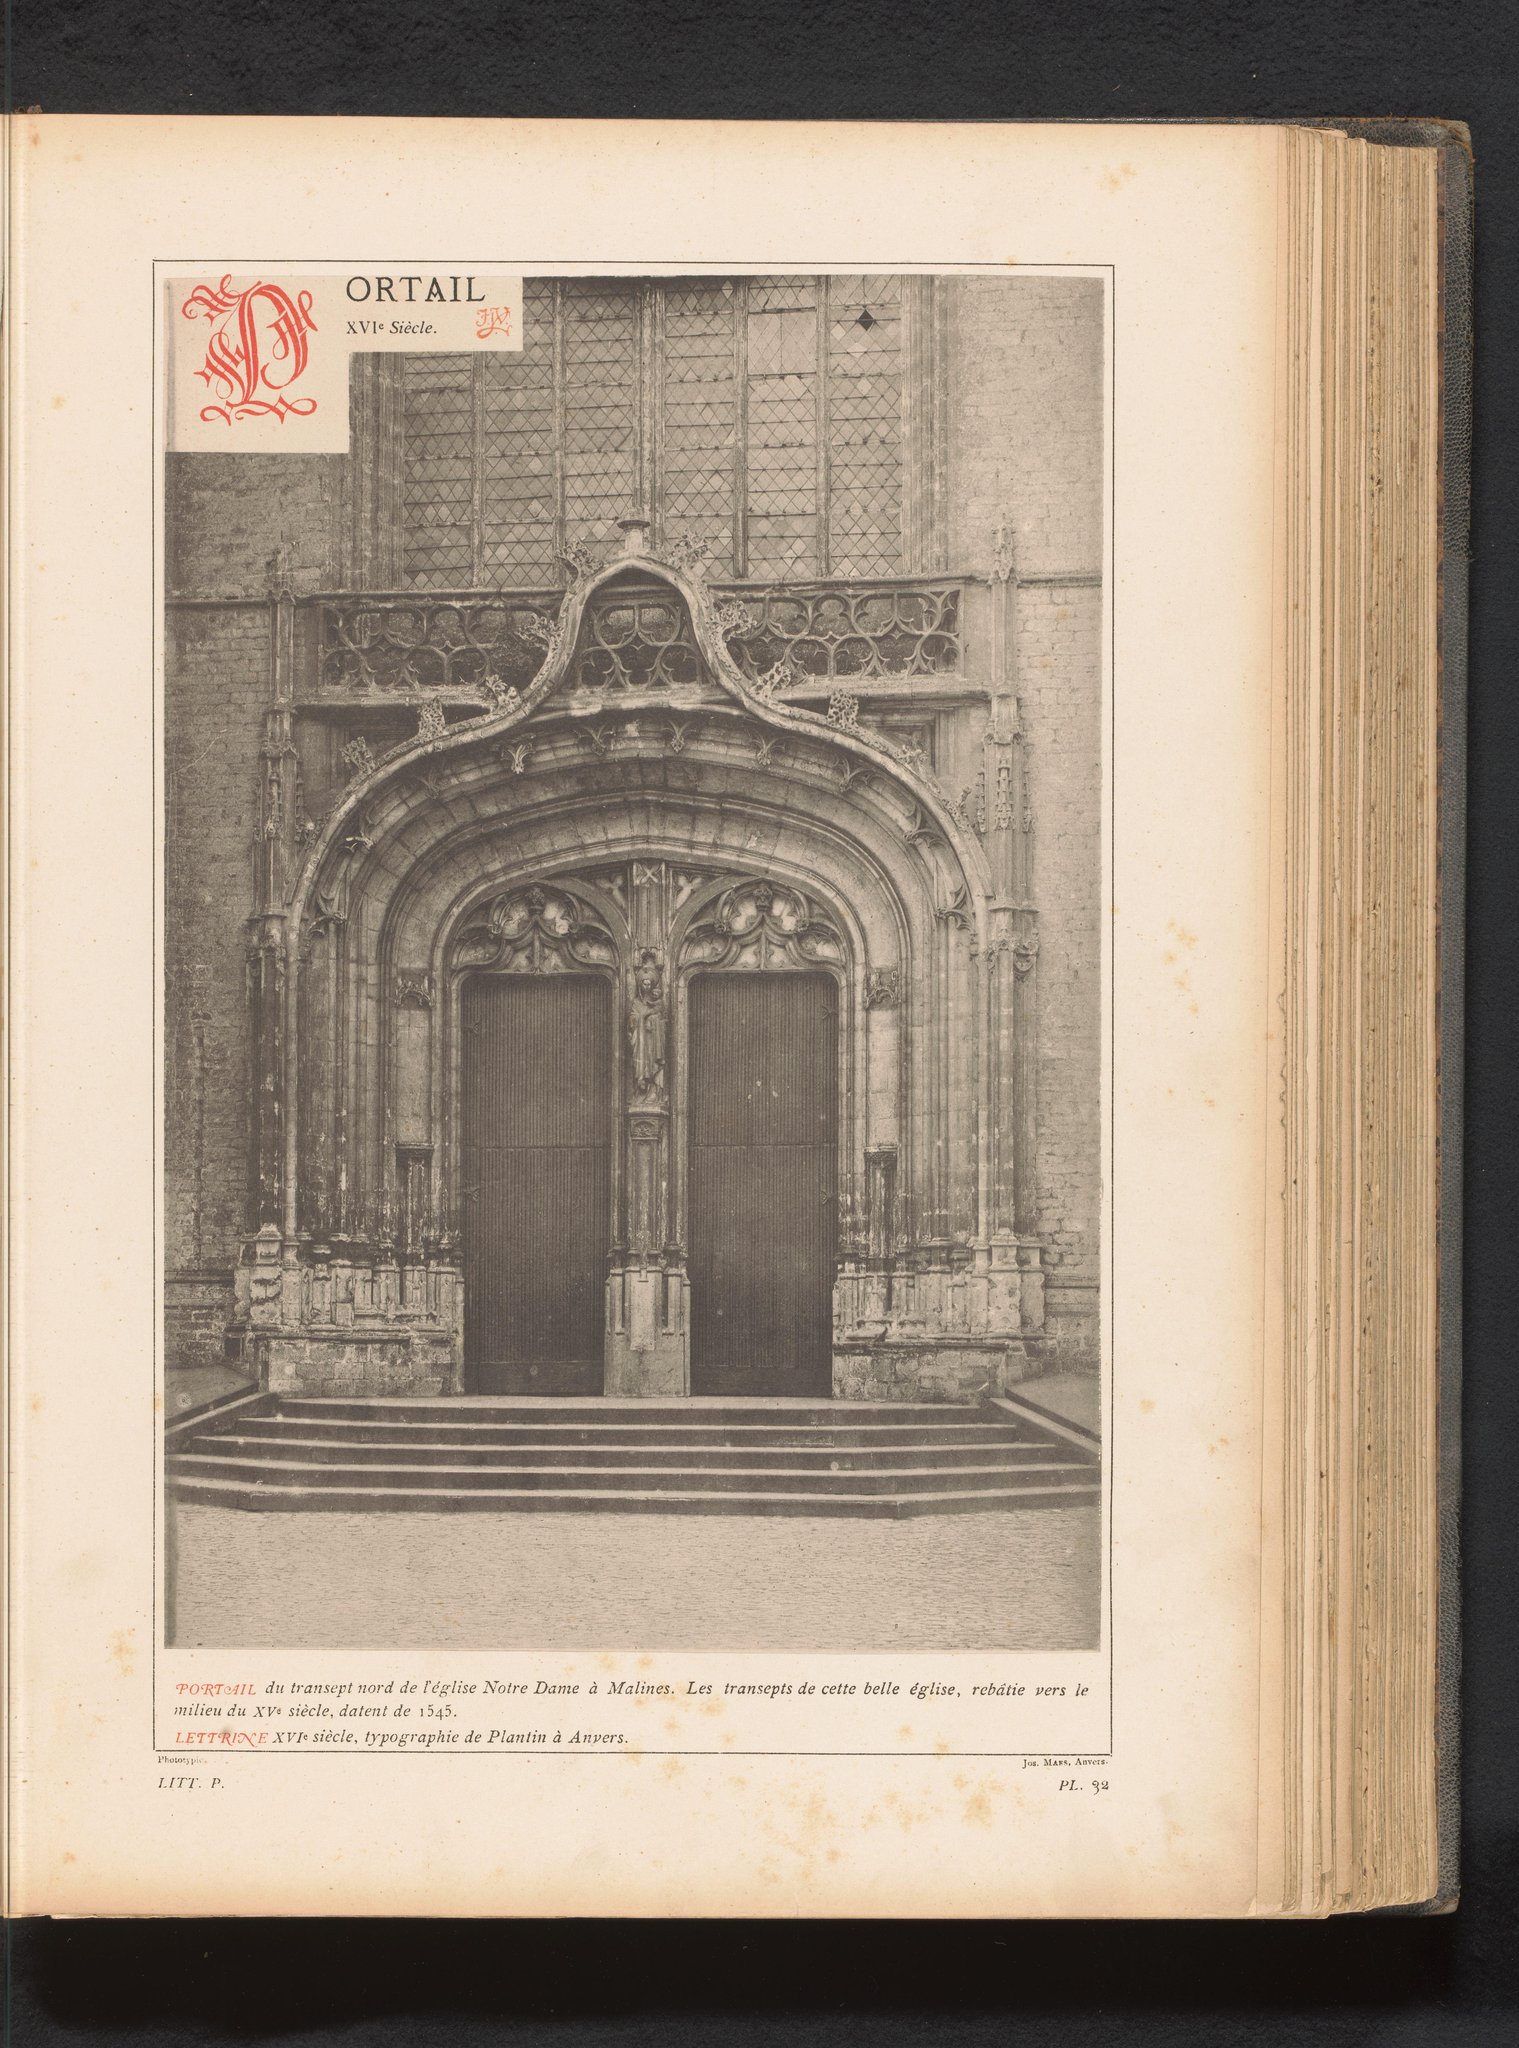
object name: page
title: Portaal van het noorder transept van de Onze-Lieve-Vrouw-over-de- Dijlekerk in Mechelen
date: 1876-1881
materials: paper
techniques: photograph, photolithography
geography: antwerp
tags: parts of church exterior and annexes: portal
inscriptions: inscription: ‘LITT. P. - PL. 32’, monogram: ‘JJvY’, inscription: ‘PORTAIL du transept nord (...)’